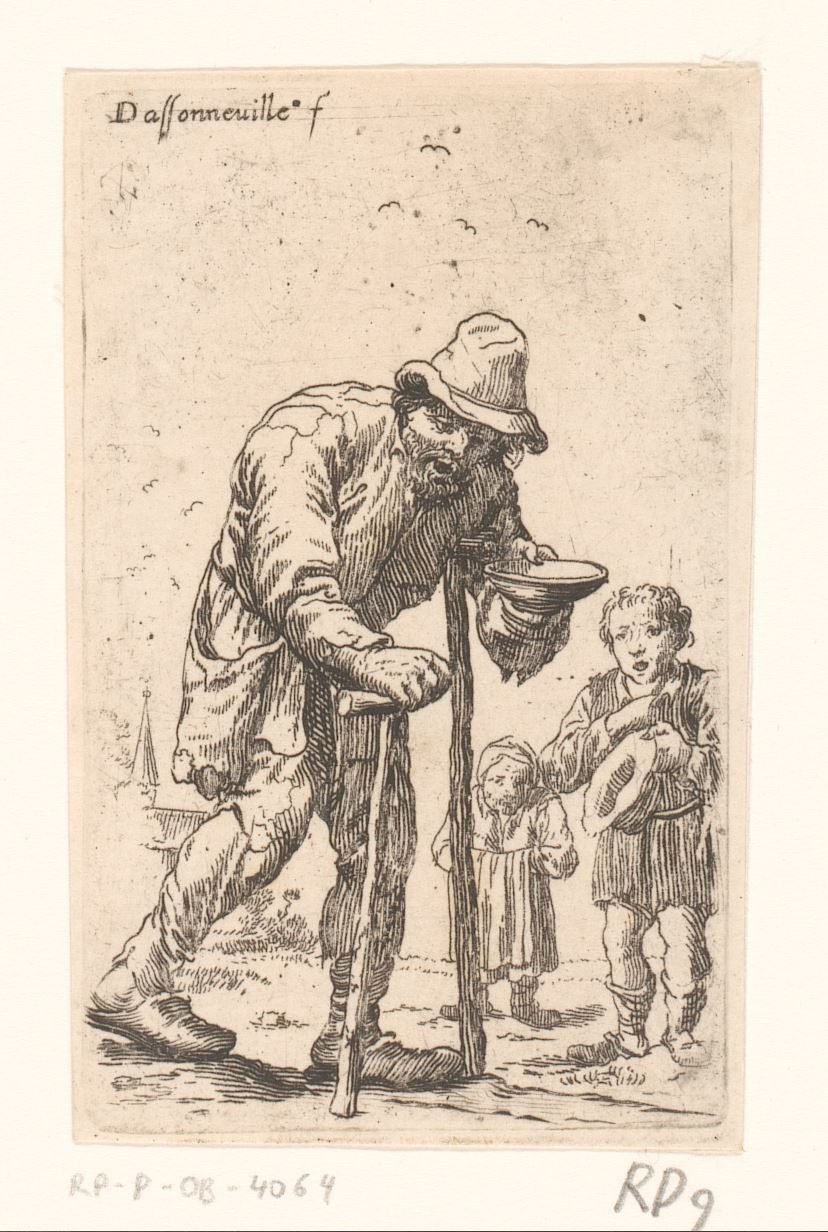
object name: print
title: Bedelaar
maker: jacques dassonville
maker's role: print maker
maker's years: 1619-1670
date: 1629-1670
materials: paper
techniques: engraving, etching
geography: france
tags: beggar